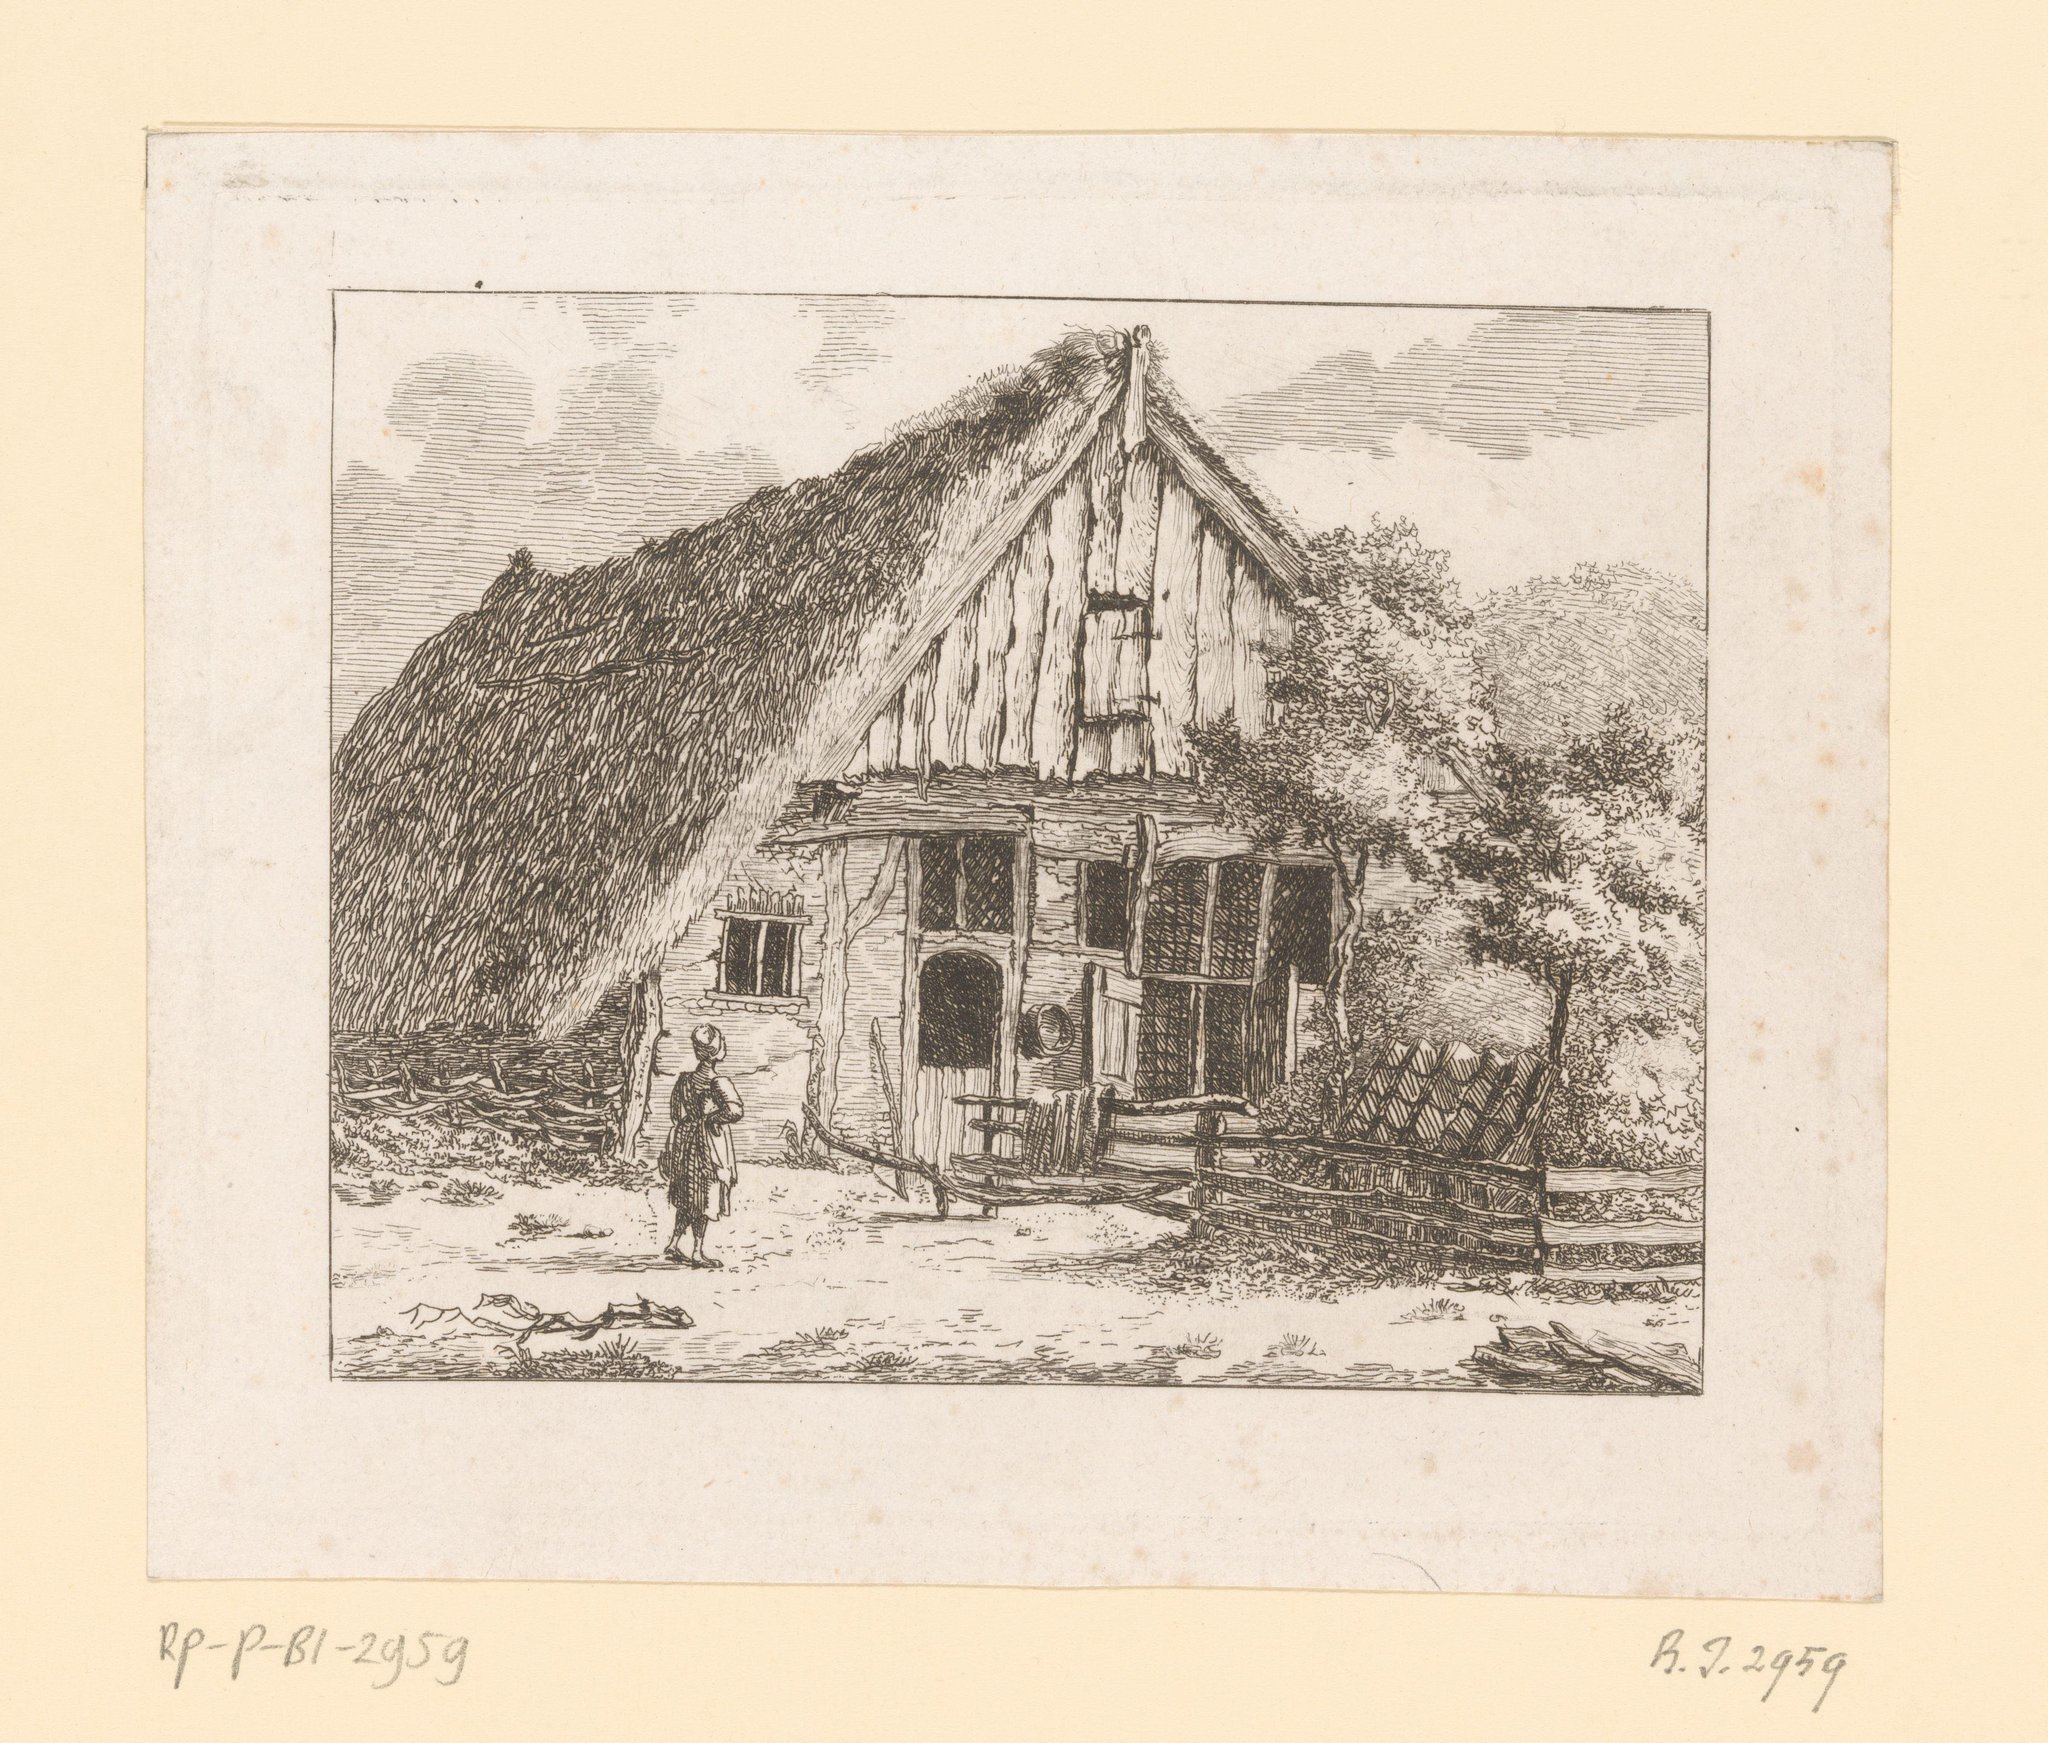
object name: print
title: Vrouw staande voor een huis te Staphorst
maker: anthonie van den bos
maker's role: draughtsman, print maker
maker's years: 1763-1838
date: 1773-1838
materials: paper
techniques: etching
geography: netherlands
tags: farm (building)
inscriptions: collector's mark: Lugt 2228